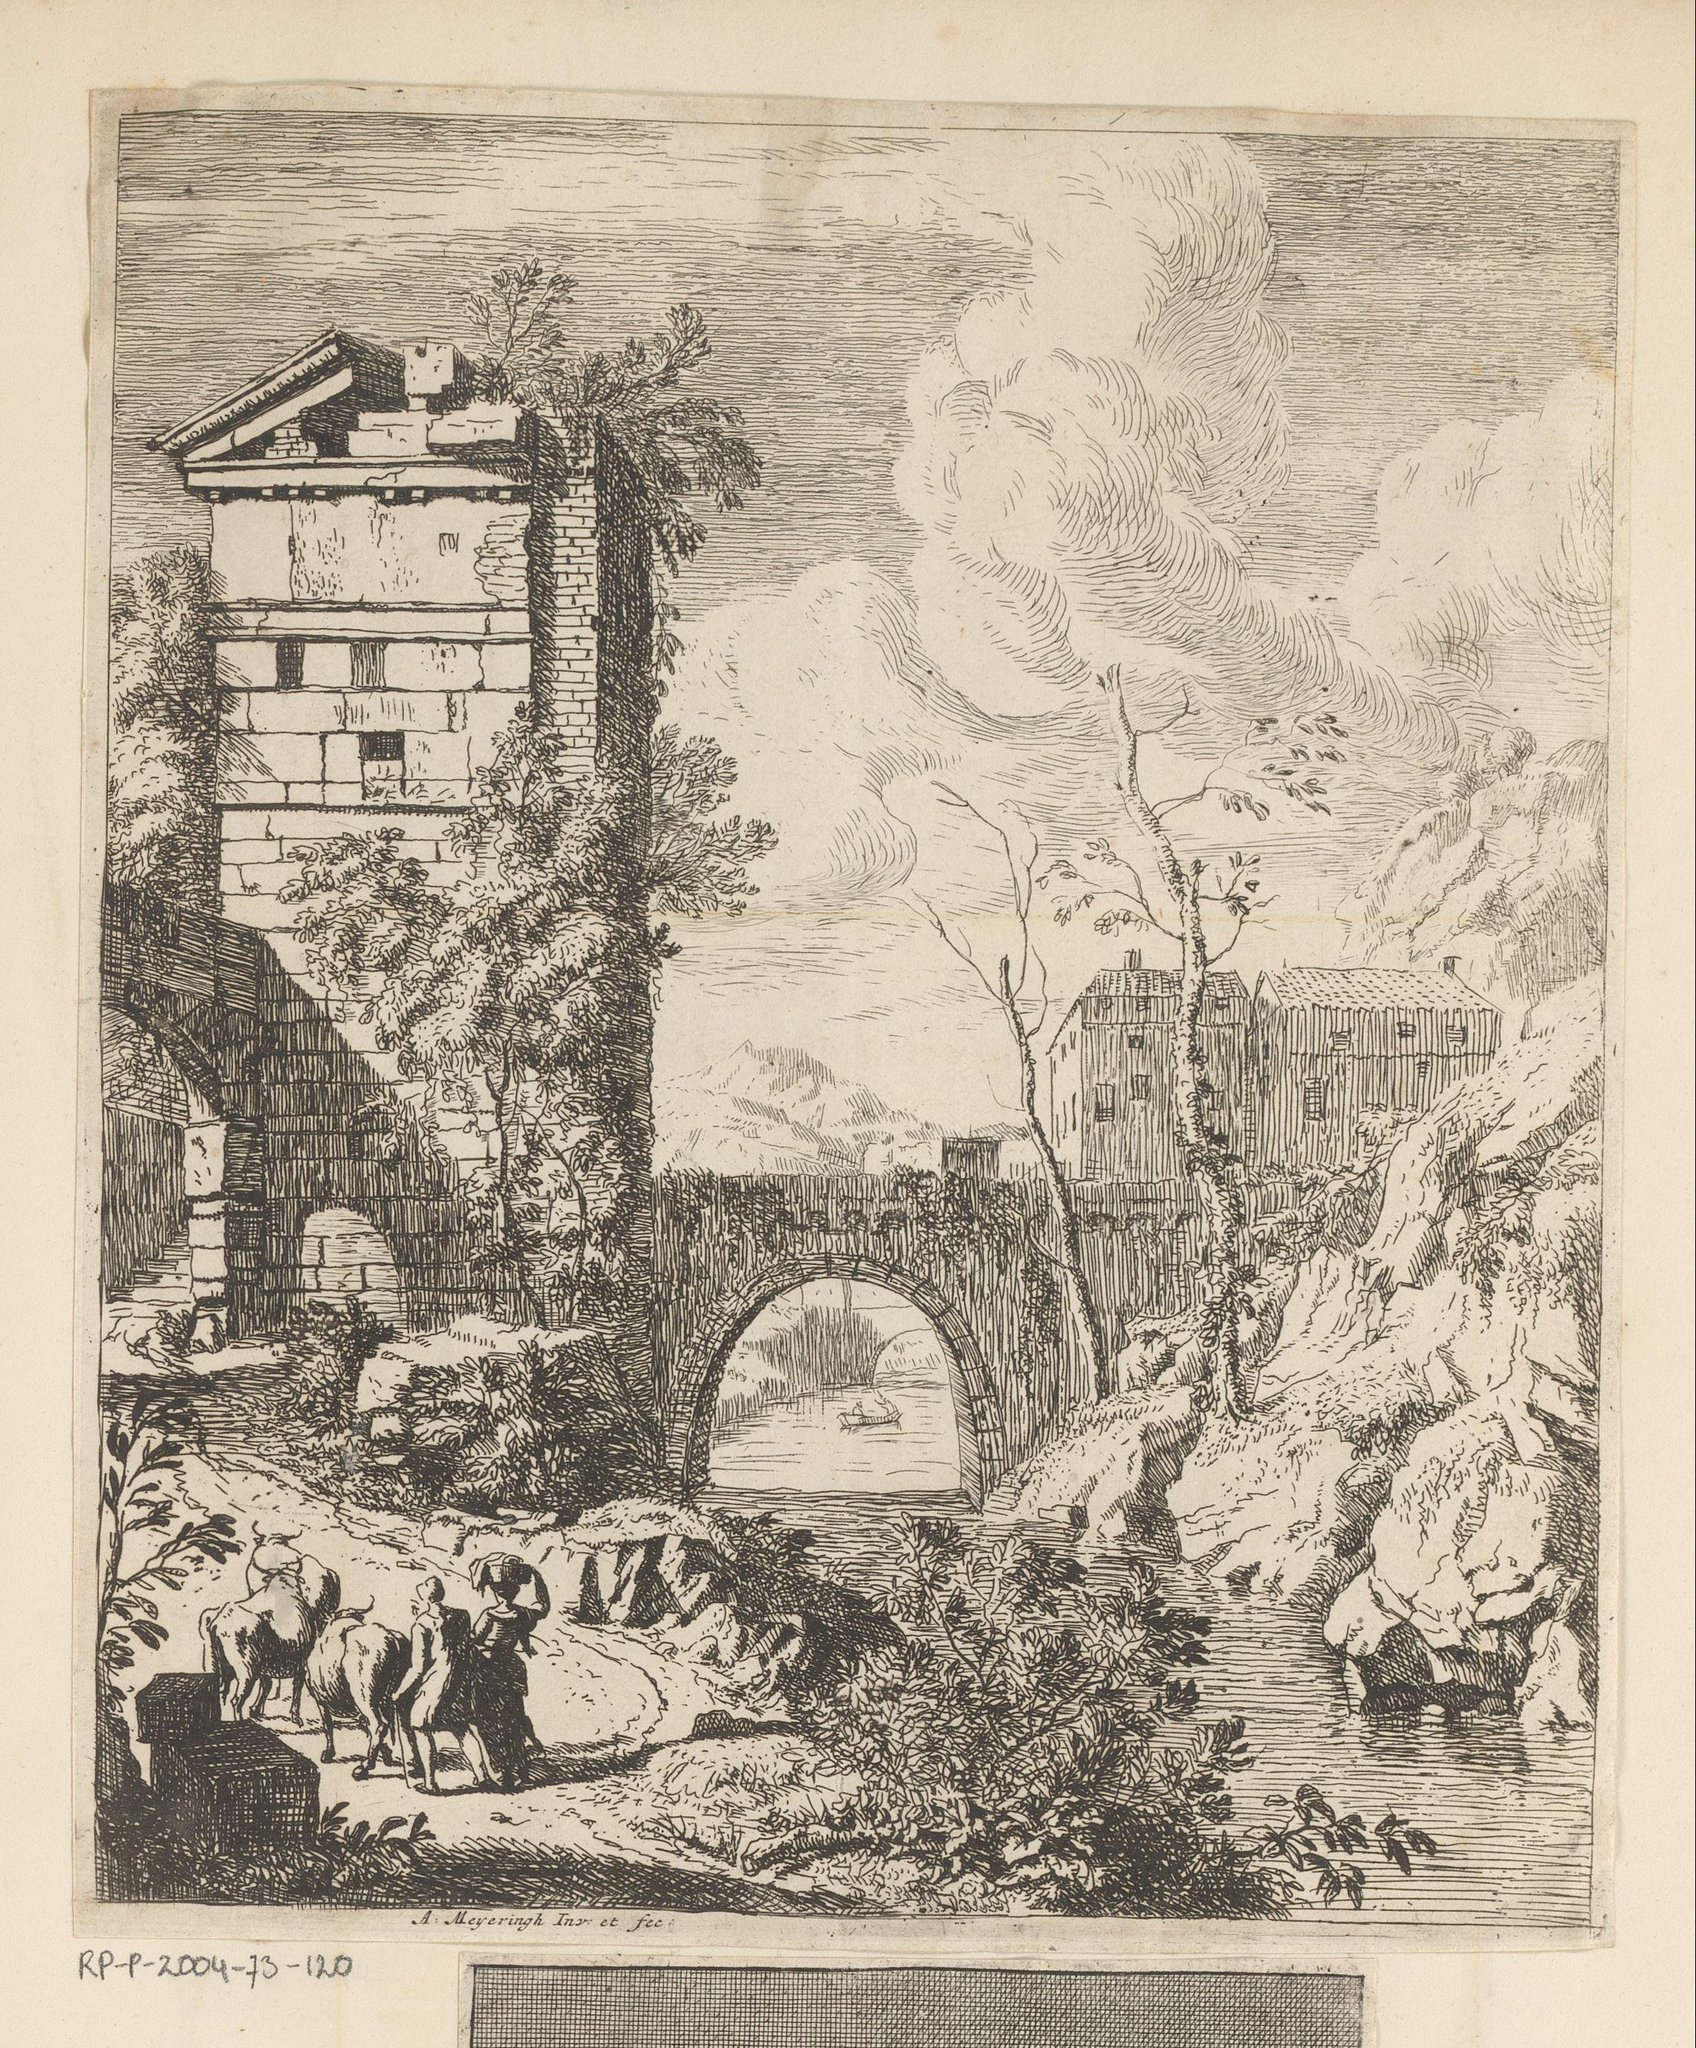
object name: album leaf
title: Landschap met een brug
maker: albert meyering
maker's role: draughtsman, print maker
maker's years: 1645-1714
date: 1695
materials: paper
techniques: etching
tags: ox, landscape with bridge, viaduct or aqueduct (+ city(-scape) with figures, staffage)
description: De samensteller heeft deze prent in het album geplakt als illustratie bij: Pilkington, Matthew en Johann Heinrich Füssli. A dictionary of painters, from the revival of the art to the present period. 4 dln. Londen: John Crowder, 1805, dl. 2, p. 334.